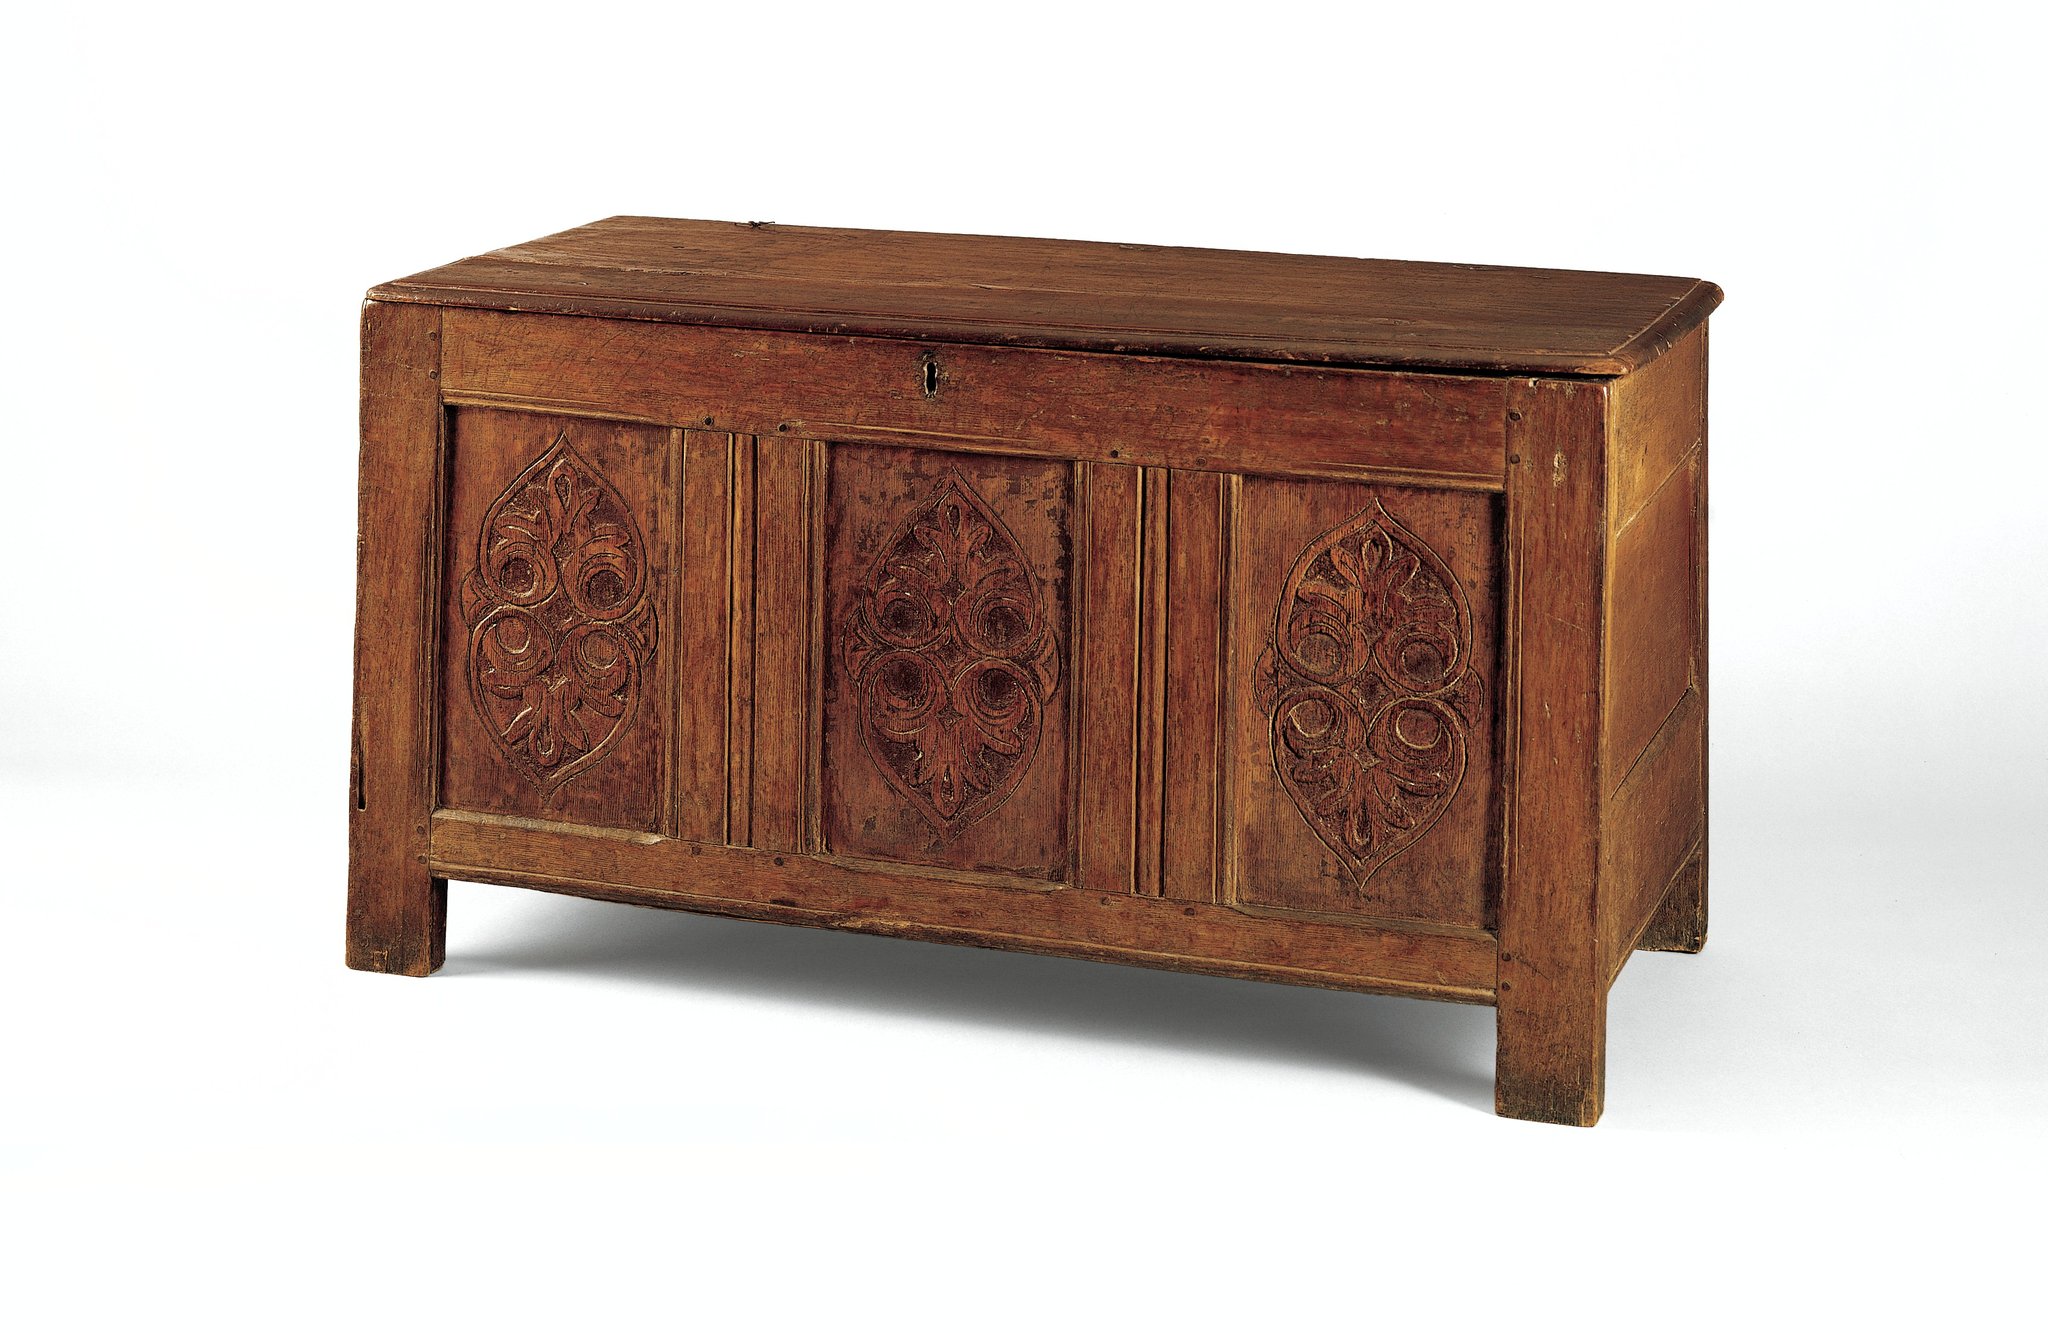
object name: chest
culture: american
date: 1675-1700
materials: wood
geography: united states